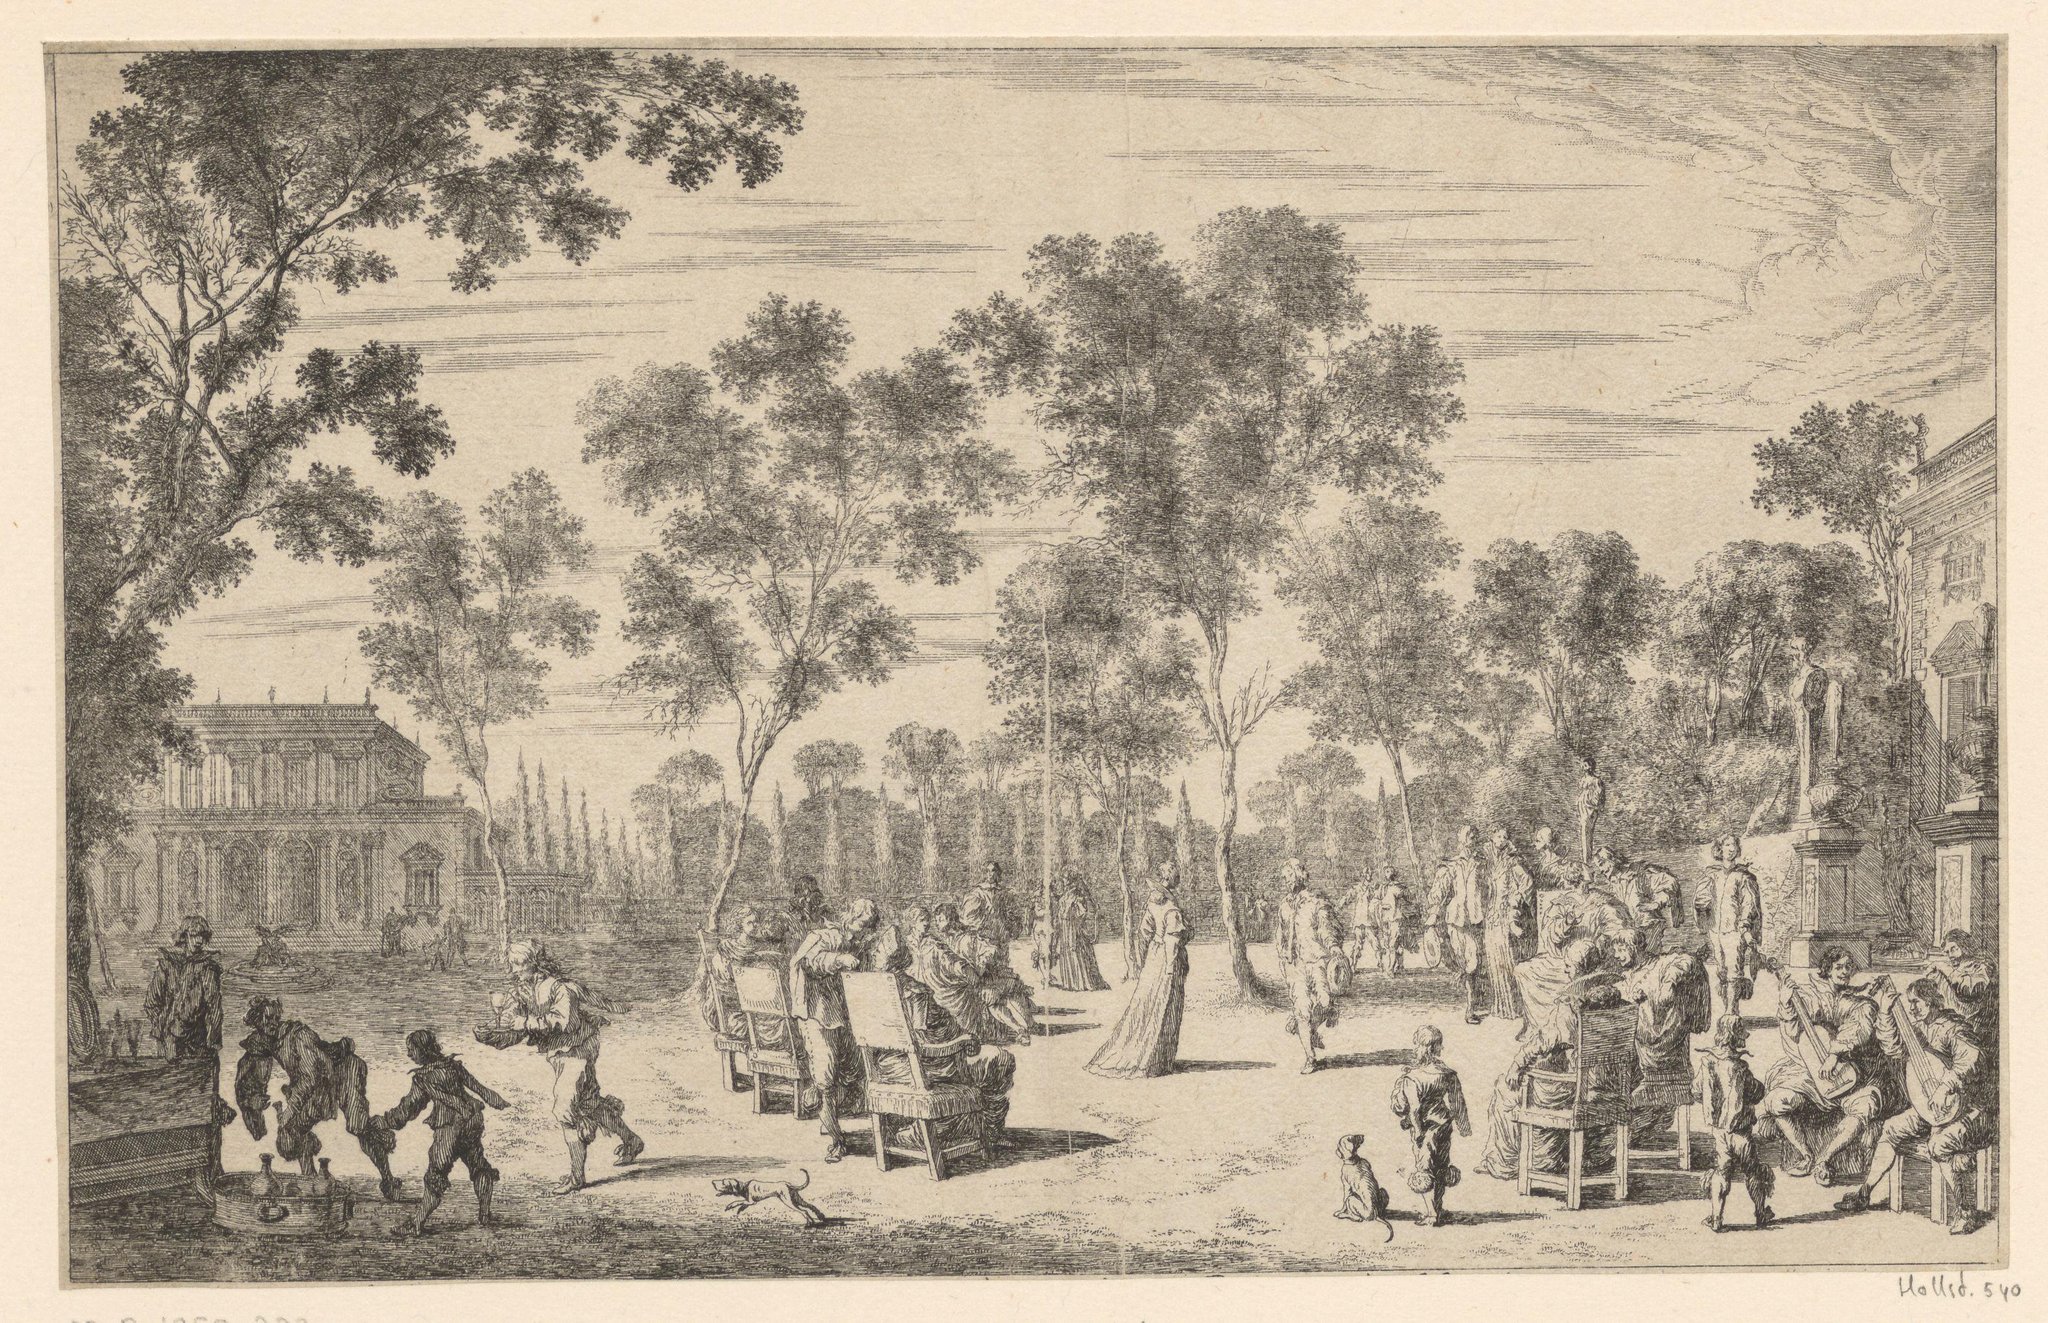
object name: print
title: Tuinfeest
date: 1636-1683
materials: paper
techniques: etching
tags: private festivities, merry company - aa - in the open air, 'fête champêtre'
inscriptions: collector's mark: Lugt 2228